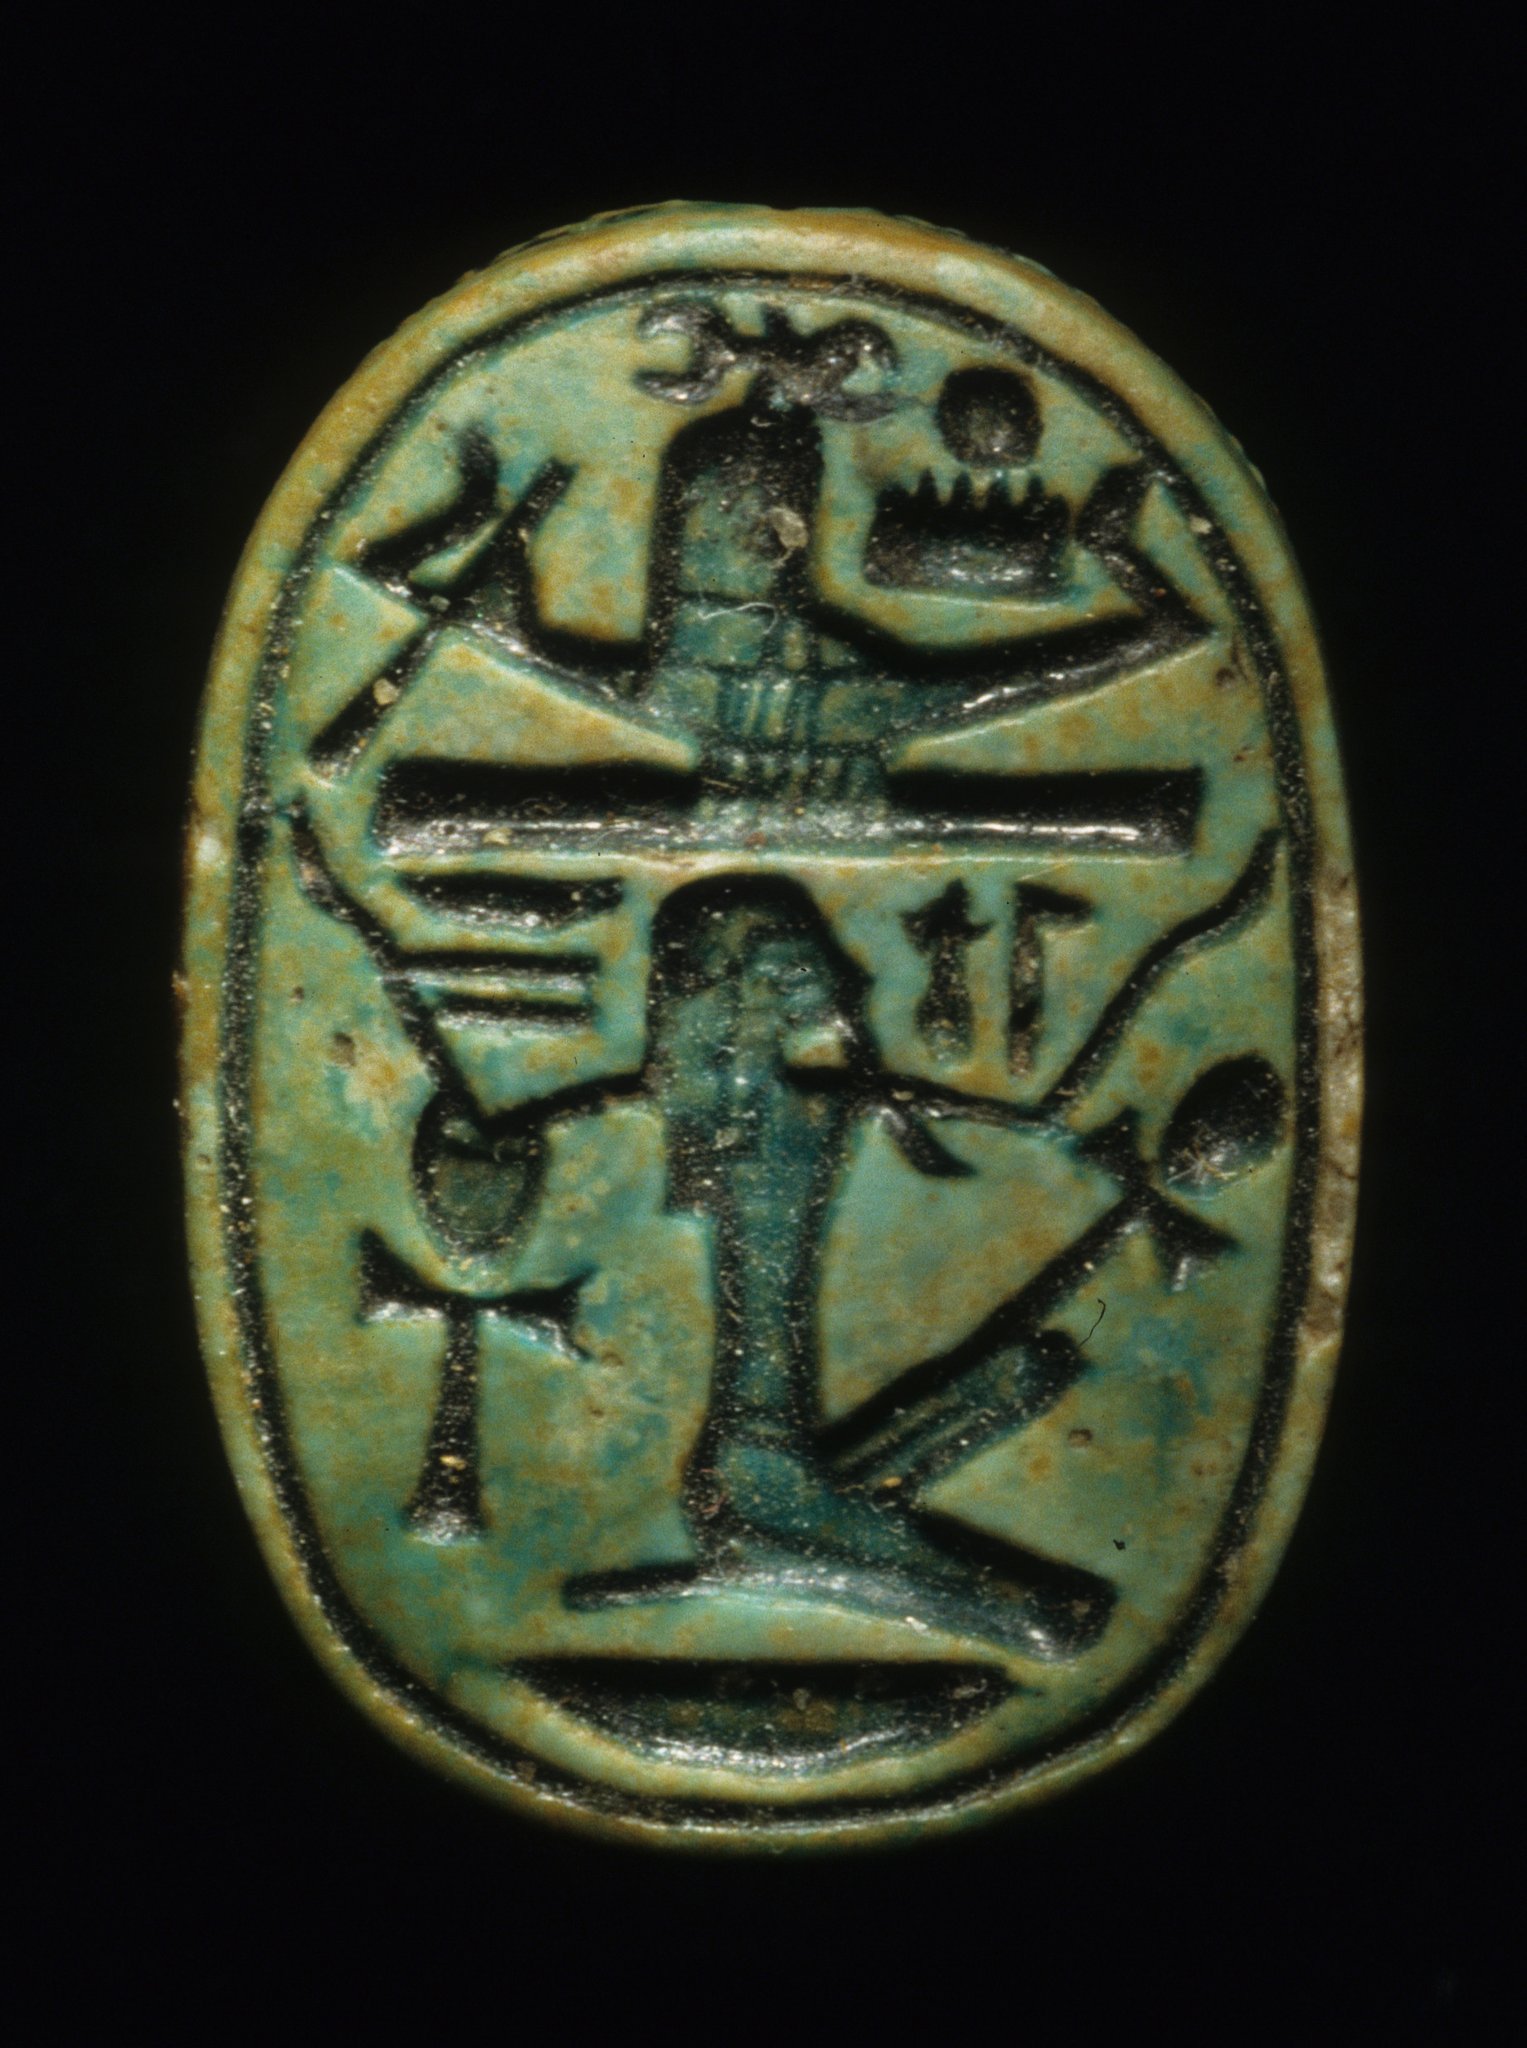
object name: scarab, sacred boat, thutmose iii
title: Scarab with Figure Upholding a Sacred Boat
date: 1479-1425 BCE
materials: stone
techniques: glazing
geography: egypt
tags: hieroglyphs,scarabs,boats